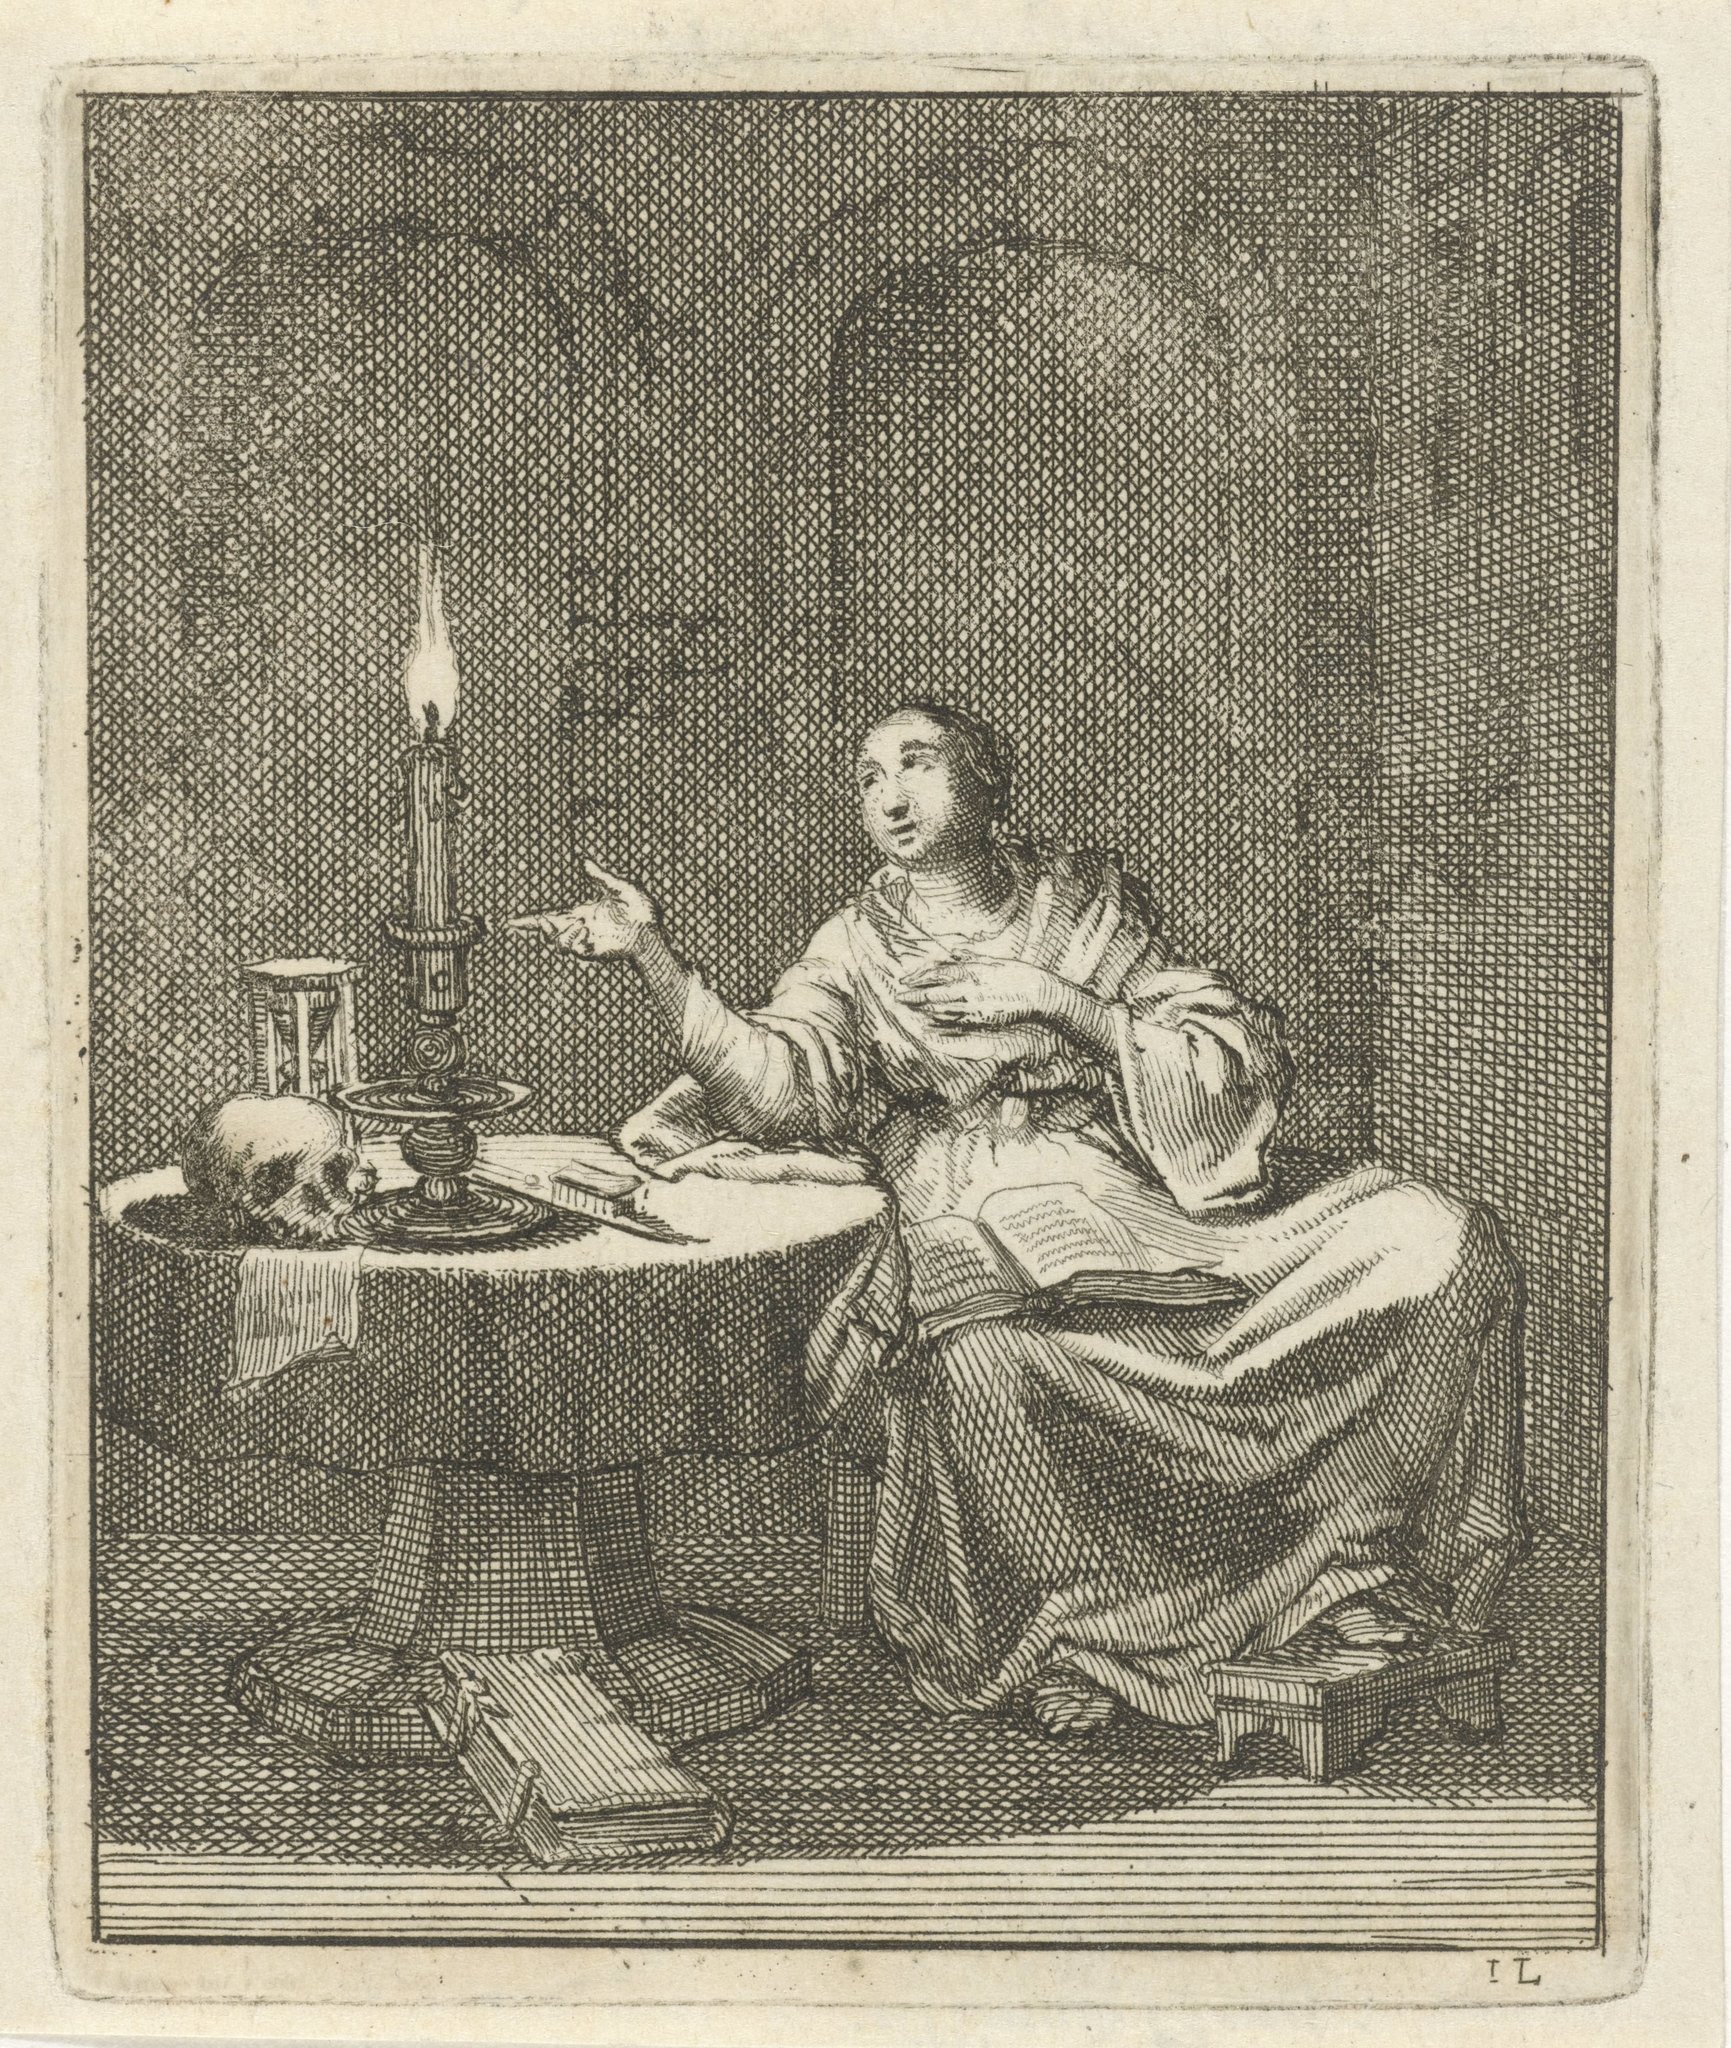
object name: book illustration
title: Vrouw zittend aan een tafel waarop een brandende kaars, zandloper en een doodshoofd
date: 1687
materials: paper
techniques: etching, letterpress printing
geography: amsterdam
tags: 'vanitas' symbols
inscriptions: collector's mark: Lugt 2228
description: Illustratie uit: Luyken, Jan. Voncken der liefde Jesu, van het godtbegerende zielenvier. Amsterdam: Pieter Arentsz (II), 1687, p. 22.